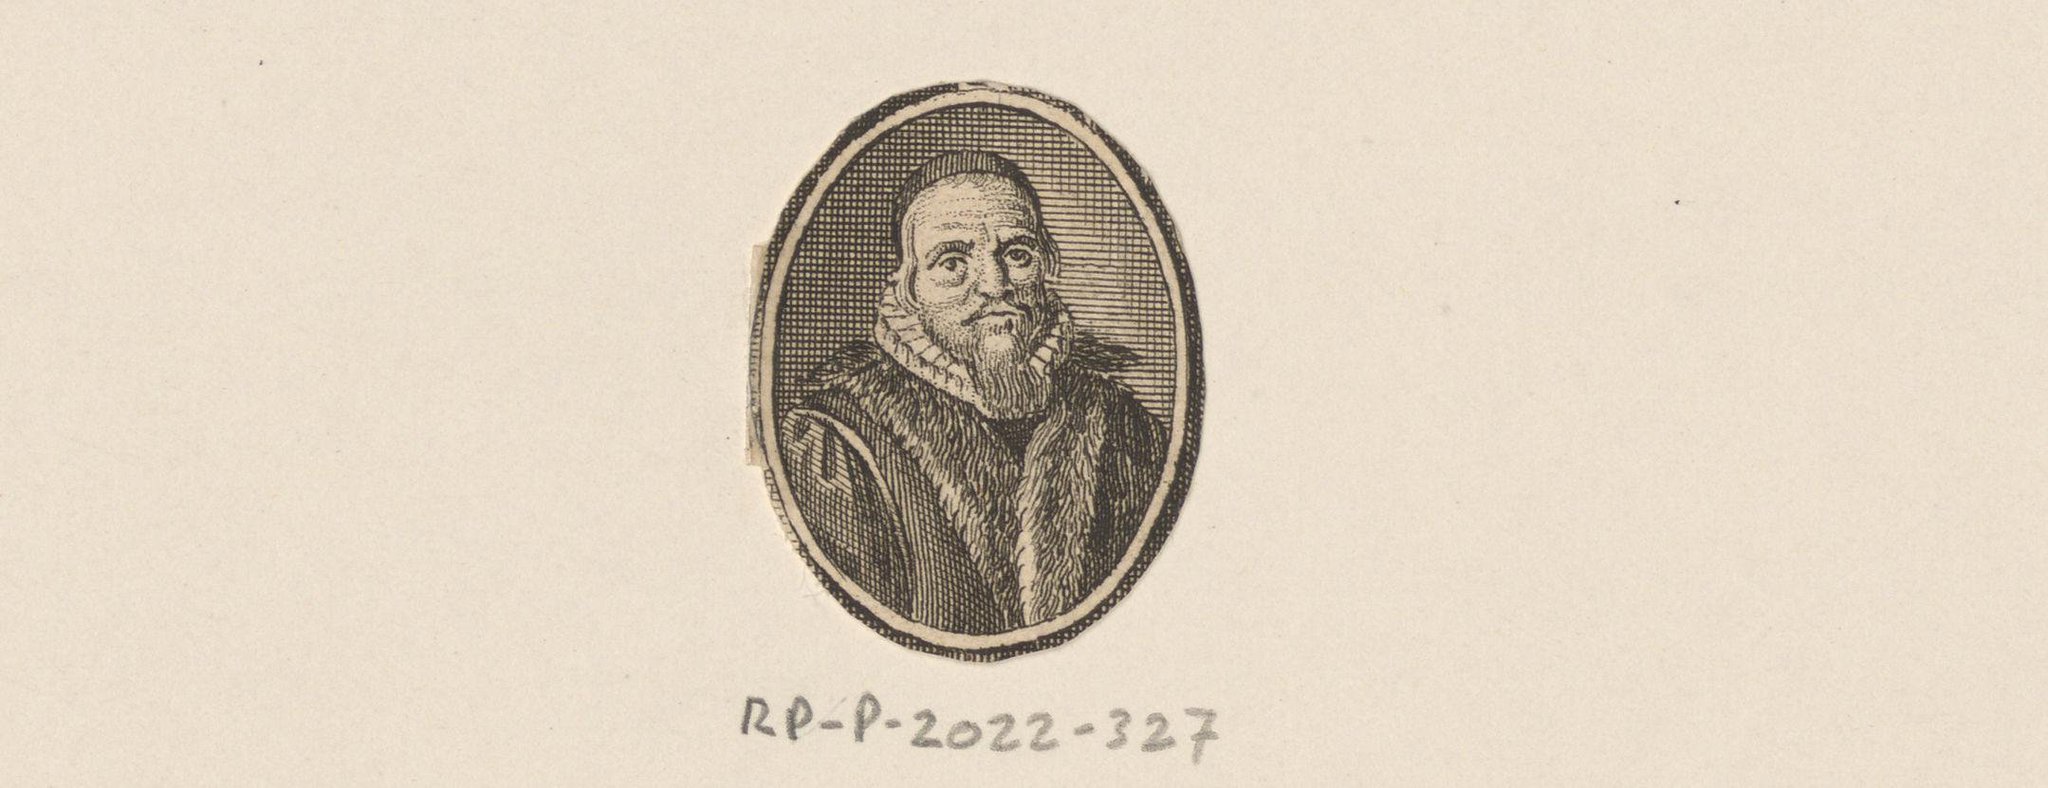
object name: print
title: Portret van Franciscus Junius I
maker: Anonymous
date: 1650-1749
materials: paper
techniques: etching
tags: leiden, theologian, historical persons